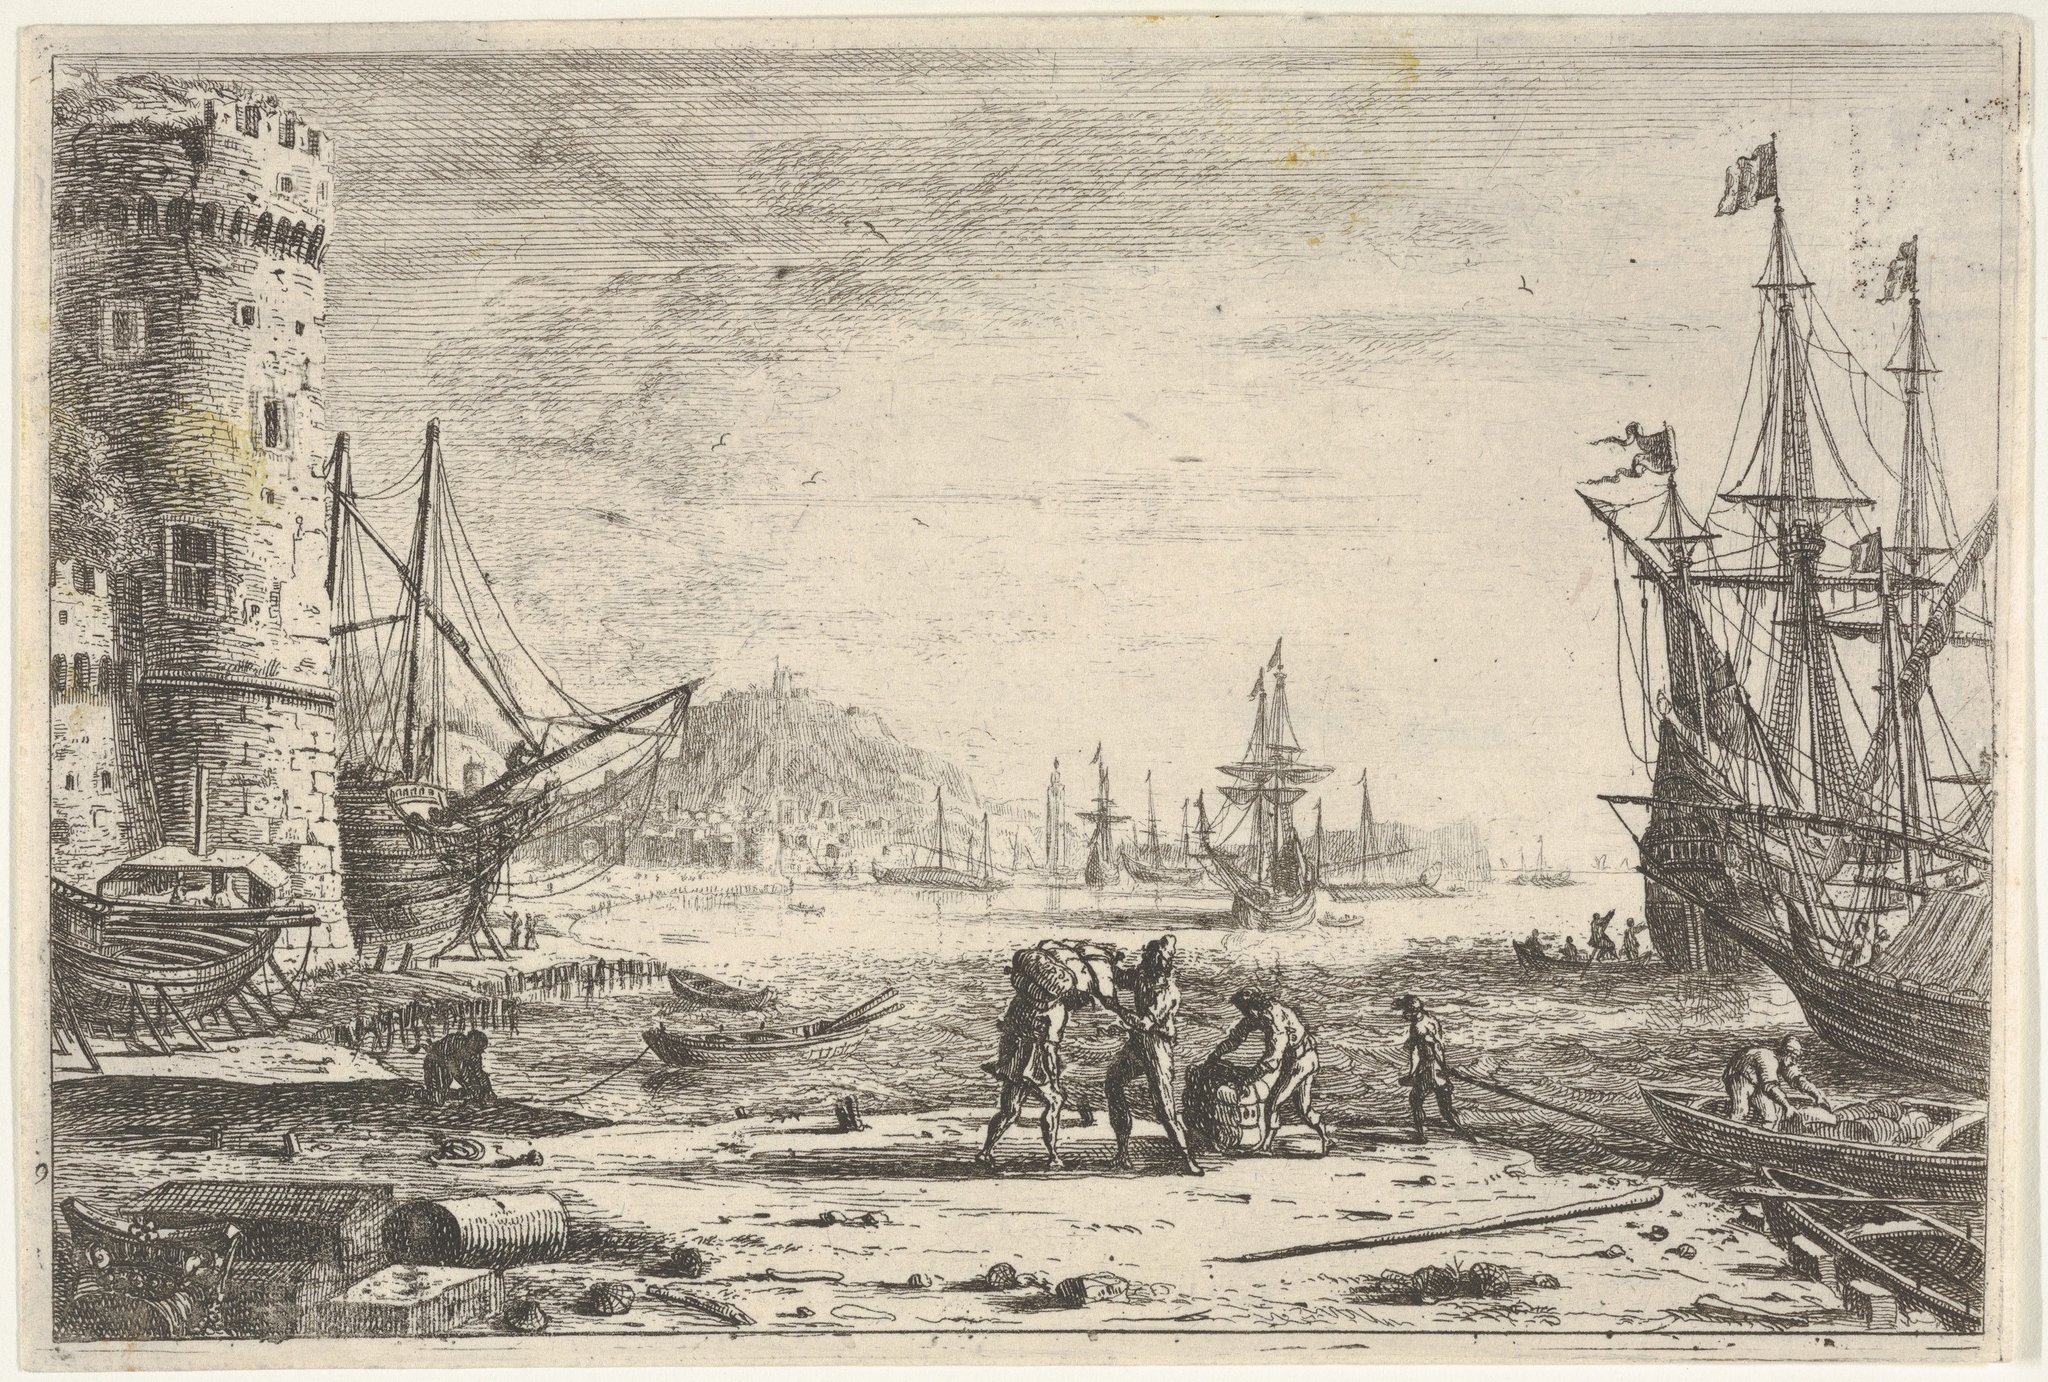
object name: print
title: Harbor with large tower at left, and figures in the foreground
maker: claude lorrain (claude gellée)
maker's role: artist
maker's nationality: french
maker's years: 1604-1682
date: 1635-1640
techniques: etching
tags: towers,men,ships